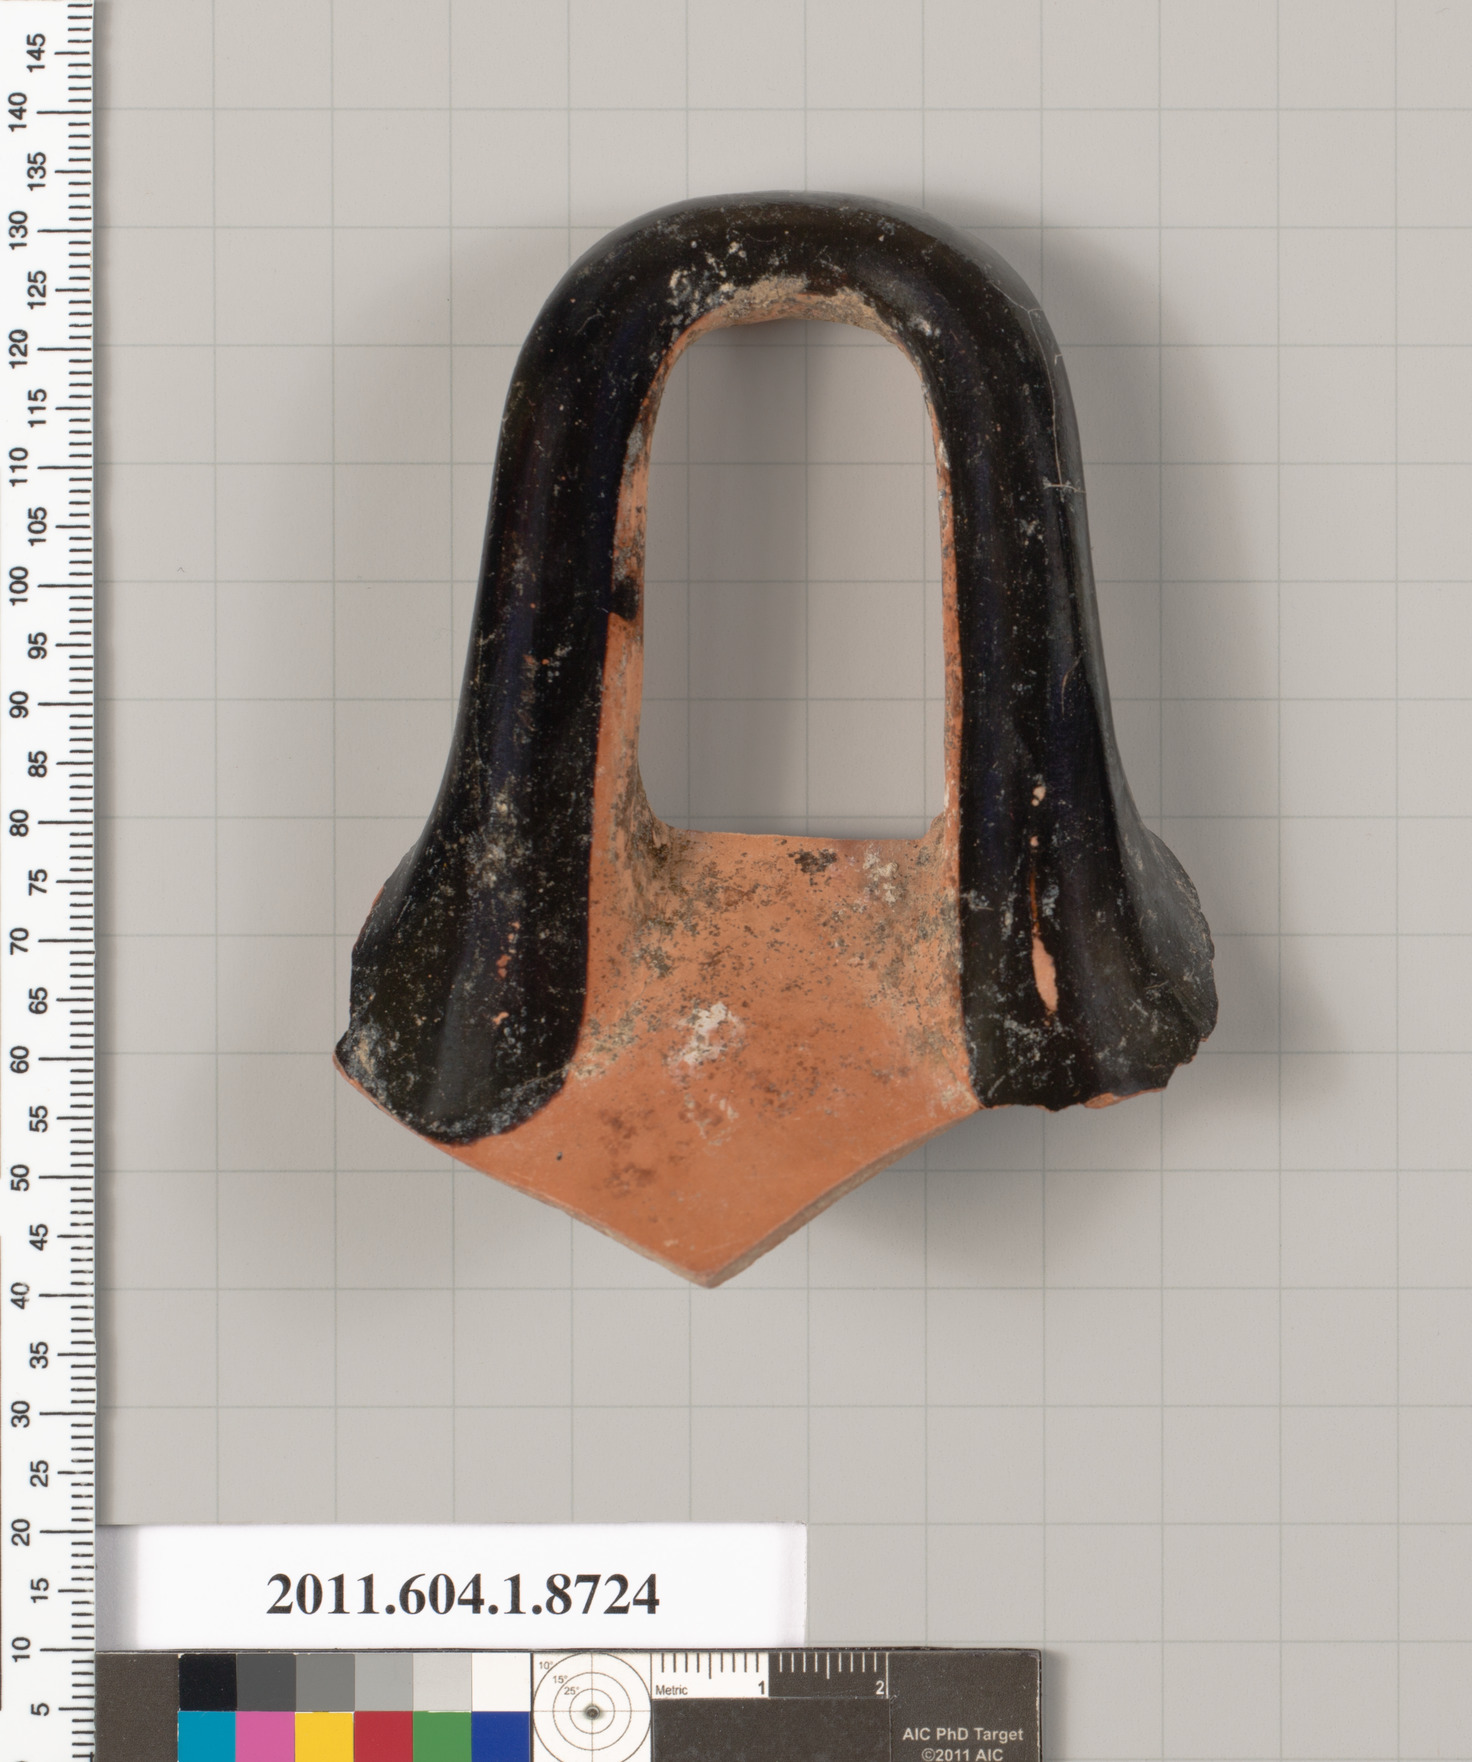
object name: kylix fragment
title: Terracotta fragment of a kylix (drinking cup)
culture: greek, attic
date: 475-451 BCE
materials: terracotta